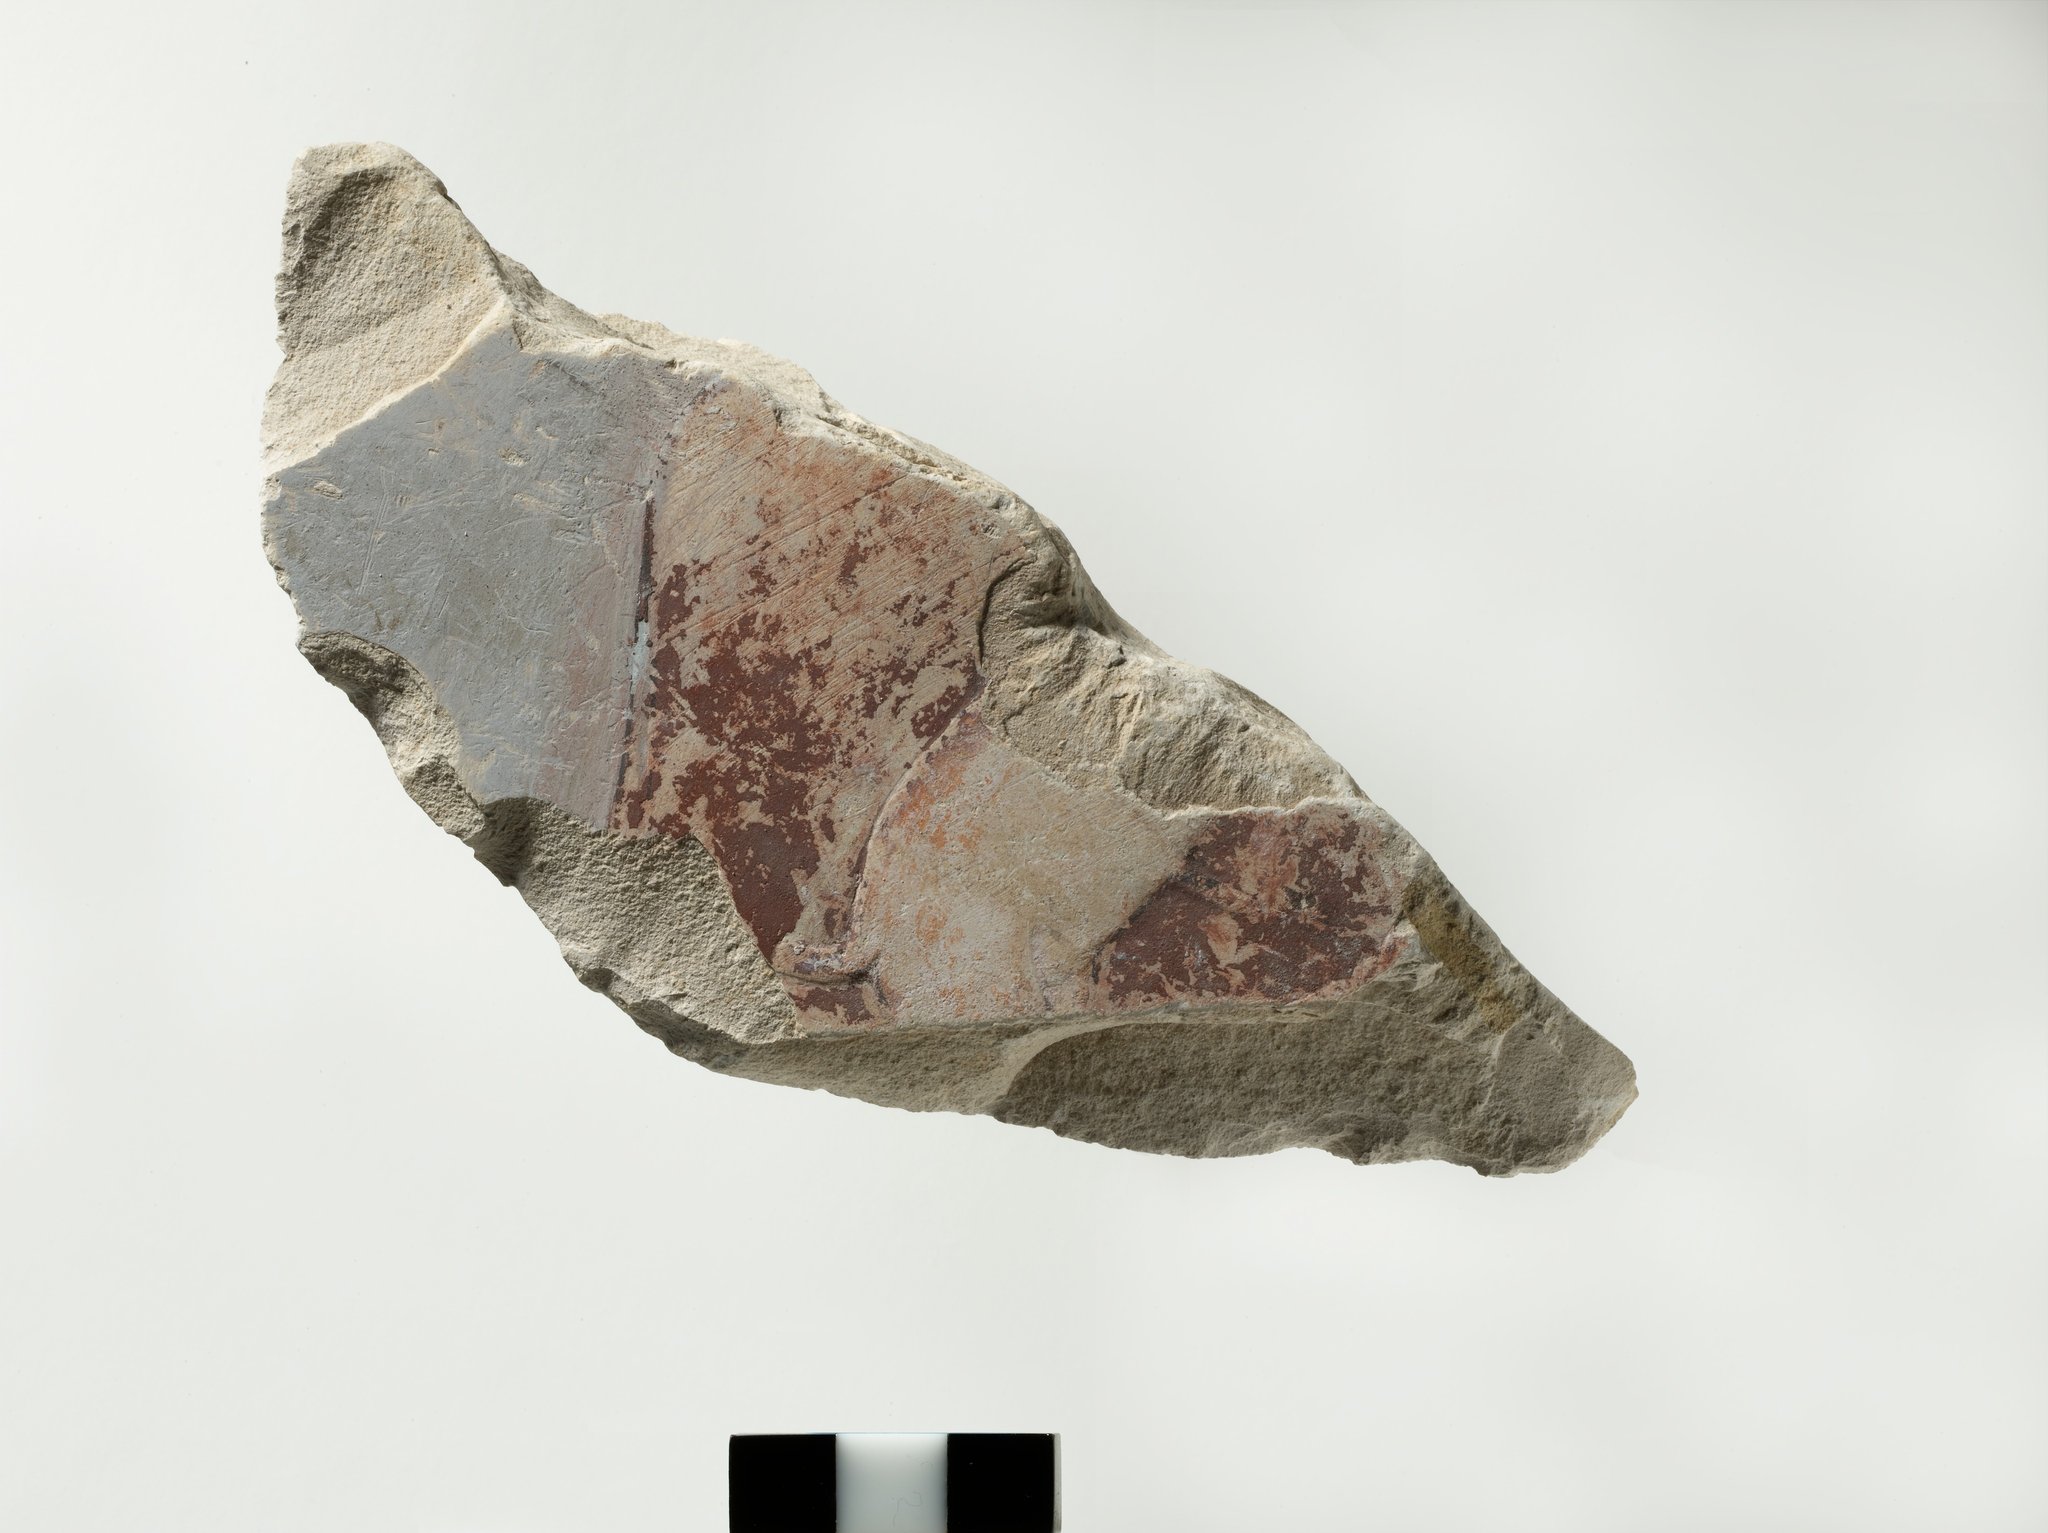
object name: relief fragment, tomb of meketre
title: Relief fragment from the tomb of Meketre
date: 1981-1975 BCE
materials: limestone, paint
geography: egypt